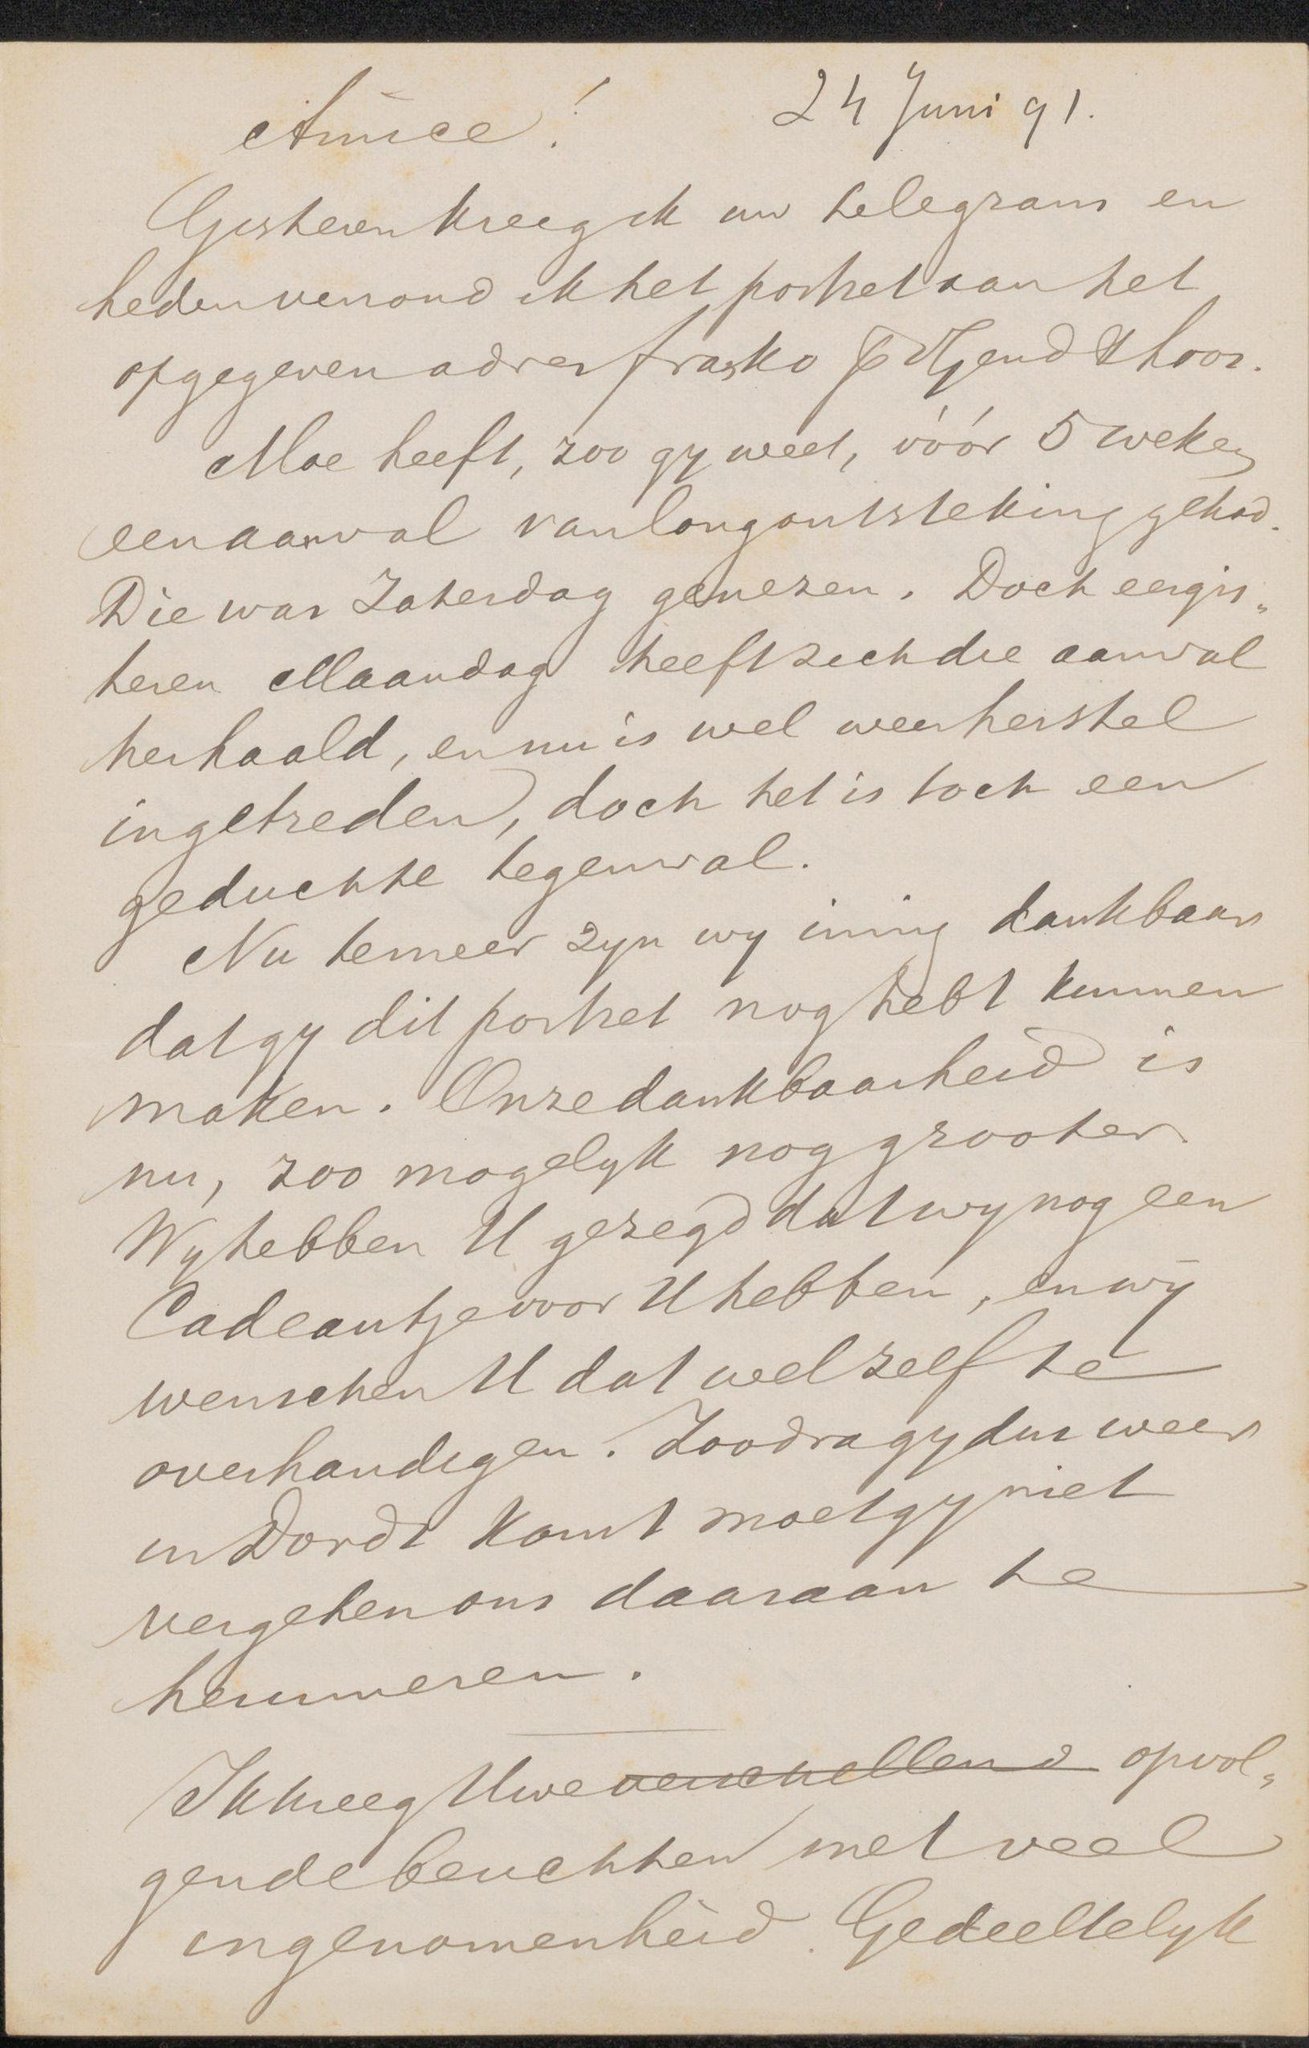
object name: letter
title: Brief aan Jan Veth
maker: martinus cornelis lebret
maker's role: verzamelaar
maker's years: 1833-1894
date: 1891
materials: ink, paper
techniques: pen, writing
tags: the hague, bernardus johannes blommers, dordrecht, designer, jan veth, paris, painter, print maker, draughtsman, camille corot, jacob maris, jacob van ruysdael, hoorn (north holland), frederik adama van scheltema, amsterdam, delft, elbert jan van wisselingh, art trade, art shop, diseases, historical persons (portraits and scenes from the life), money, london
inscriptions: collector's mark: ‘RPK’